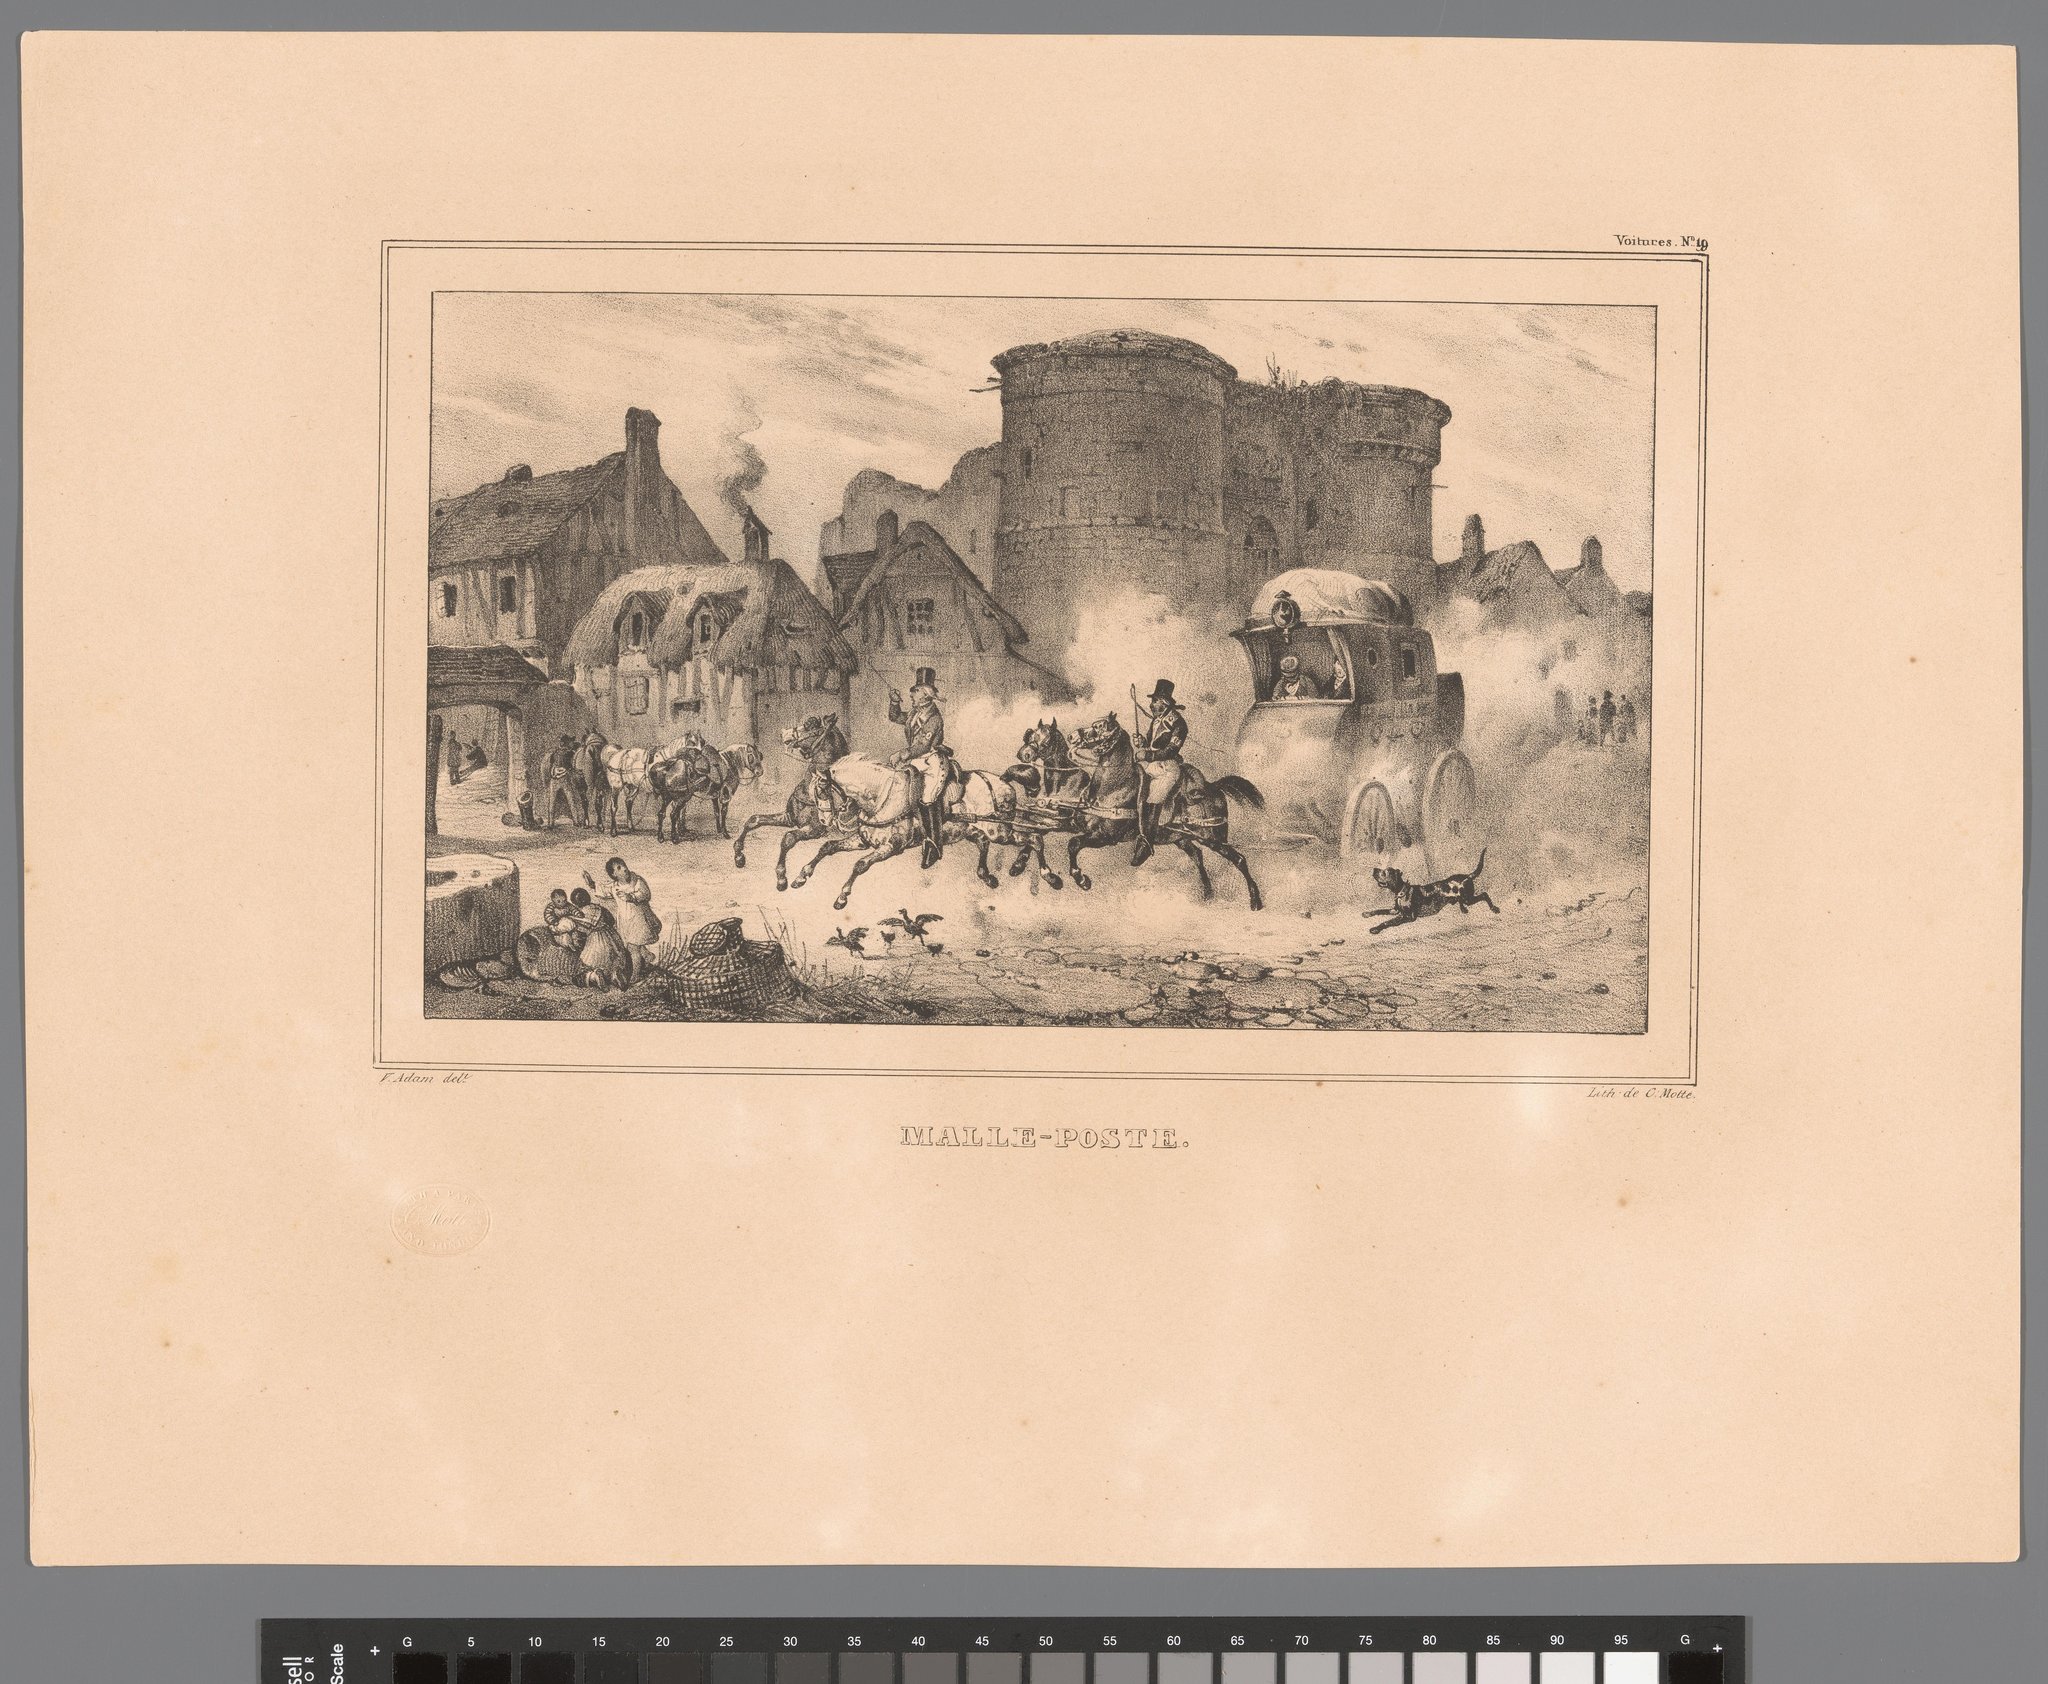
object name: print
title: Allerlei soorten voertuigen (2)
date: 1828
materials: paper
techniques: lithograph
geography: paris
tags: mail-coach, four-wheeled vehicle drawn by more than three animals, passenger carriage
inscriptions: collector's mark: Lugt 2228, stamp: Lugt 1828b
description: De prentserie waar deze prent deel van uitmaakt werd in drie delen van twaalf prenten vanaf 1827 tot en met 1830 gepubliceerd. Elk van de drie delen werd voorzien van een aparte omslag. De postkoets vervoerde poststukken en vaak ook enkele reizigers.